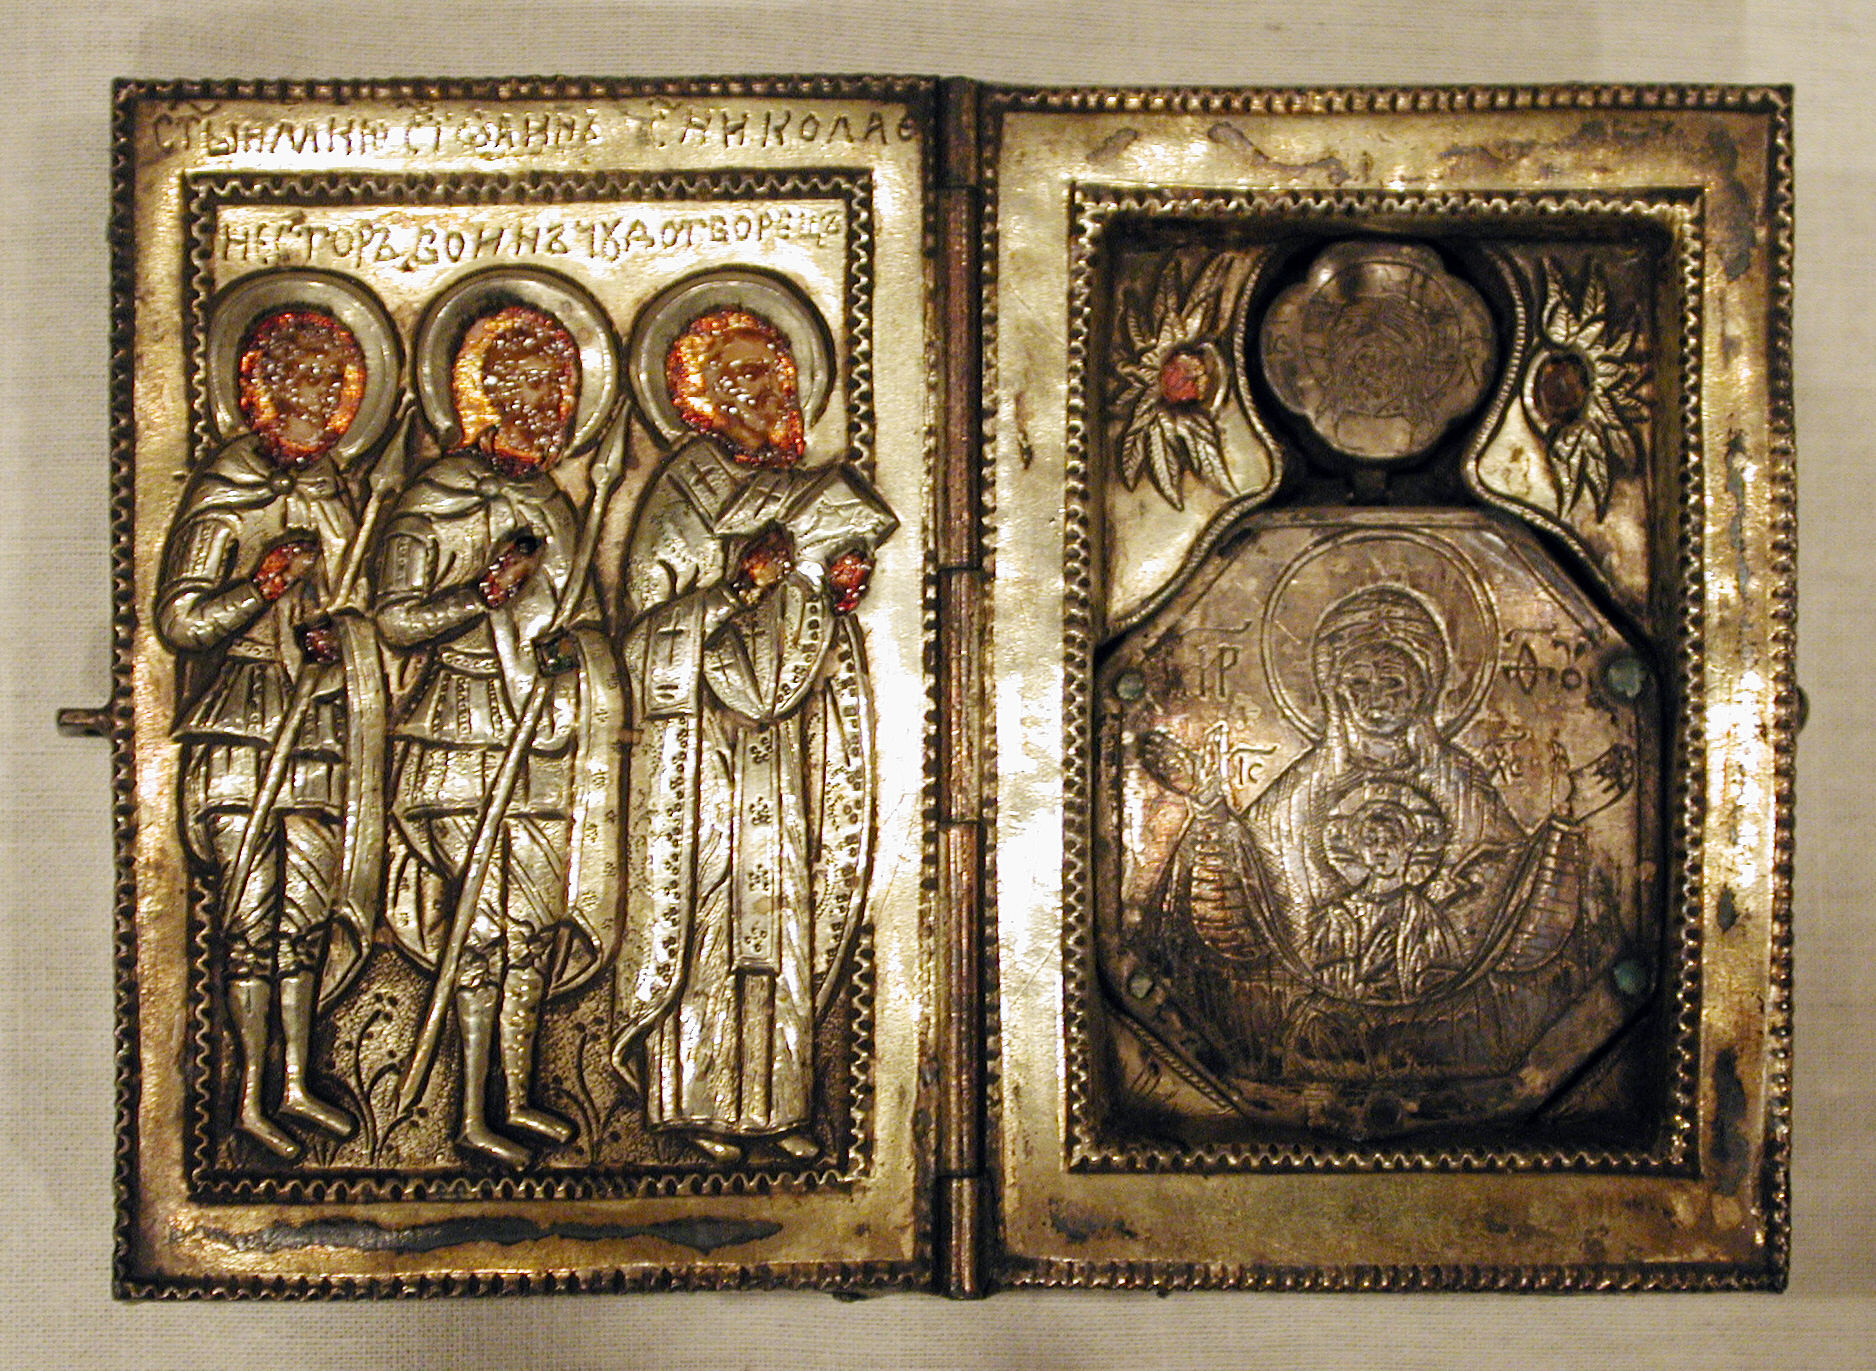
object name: diptych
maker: master bp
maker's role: maker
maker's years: 1700-1800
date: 1736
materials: silver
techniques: gilding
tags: virgin mary,saints